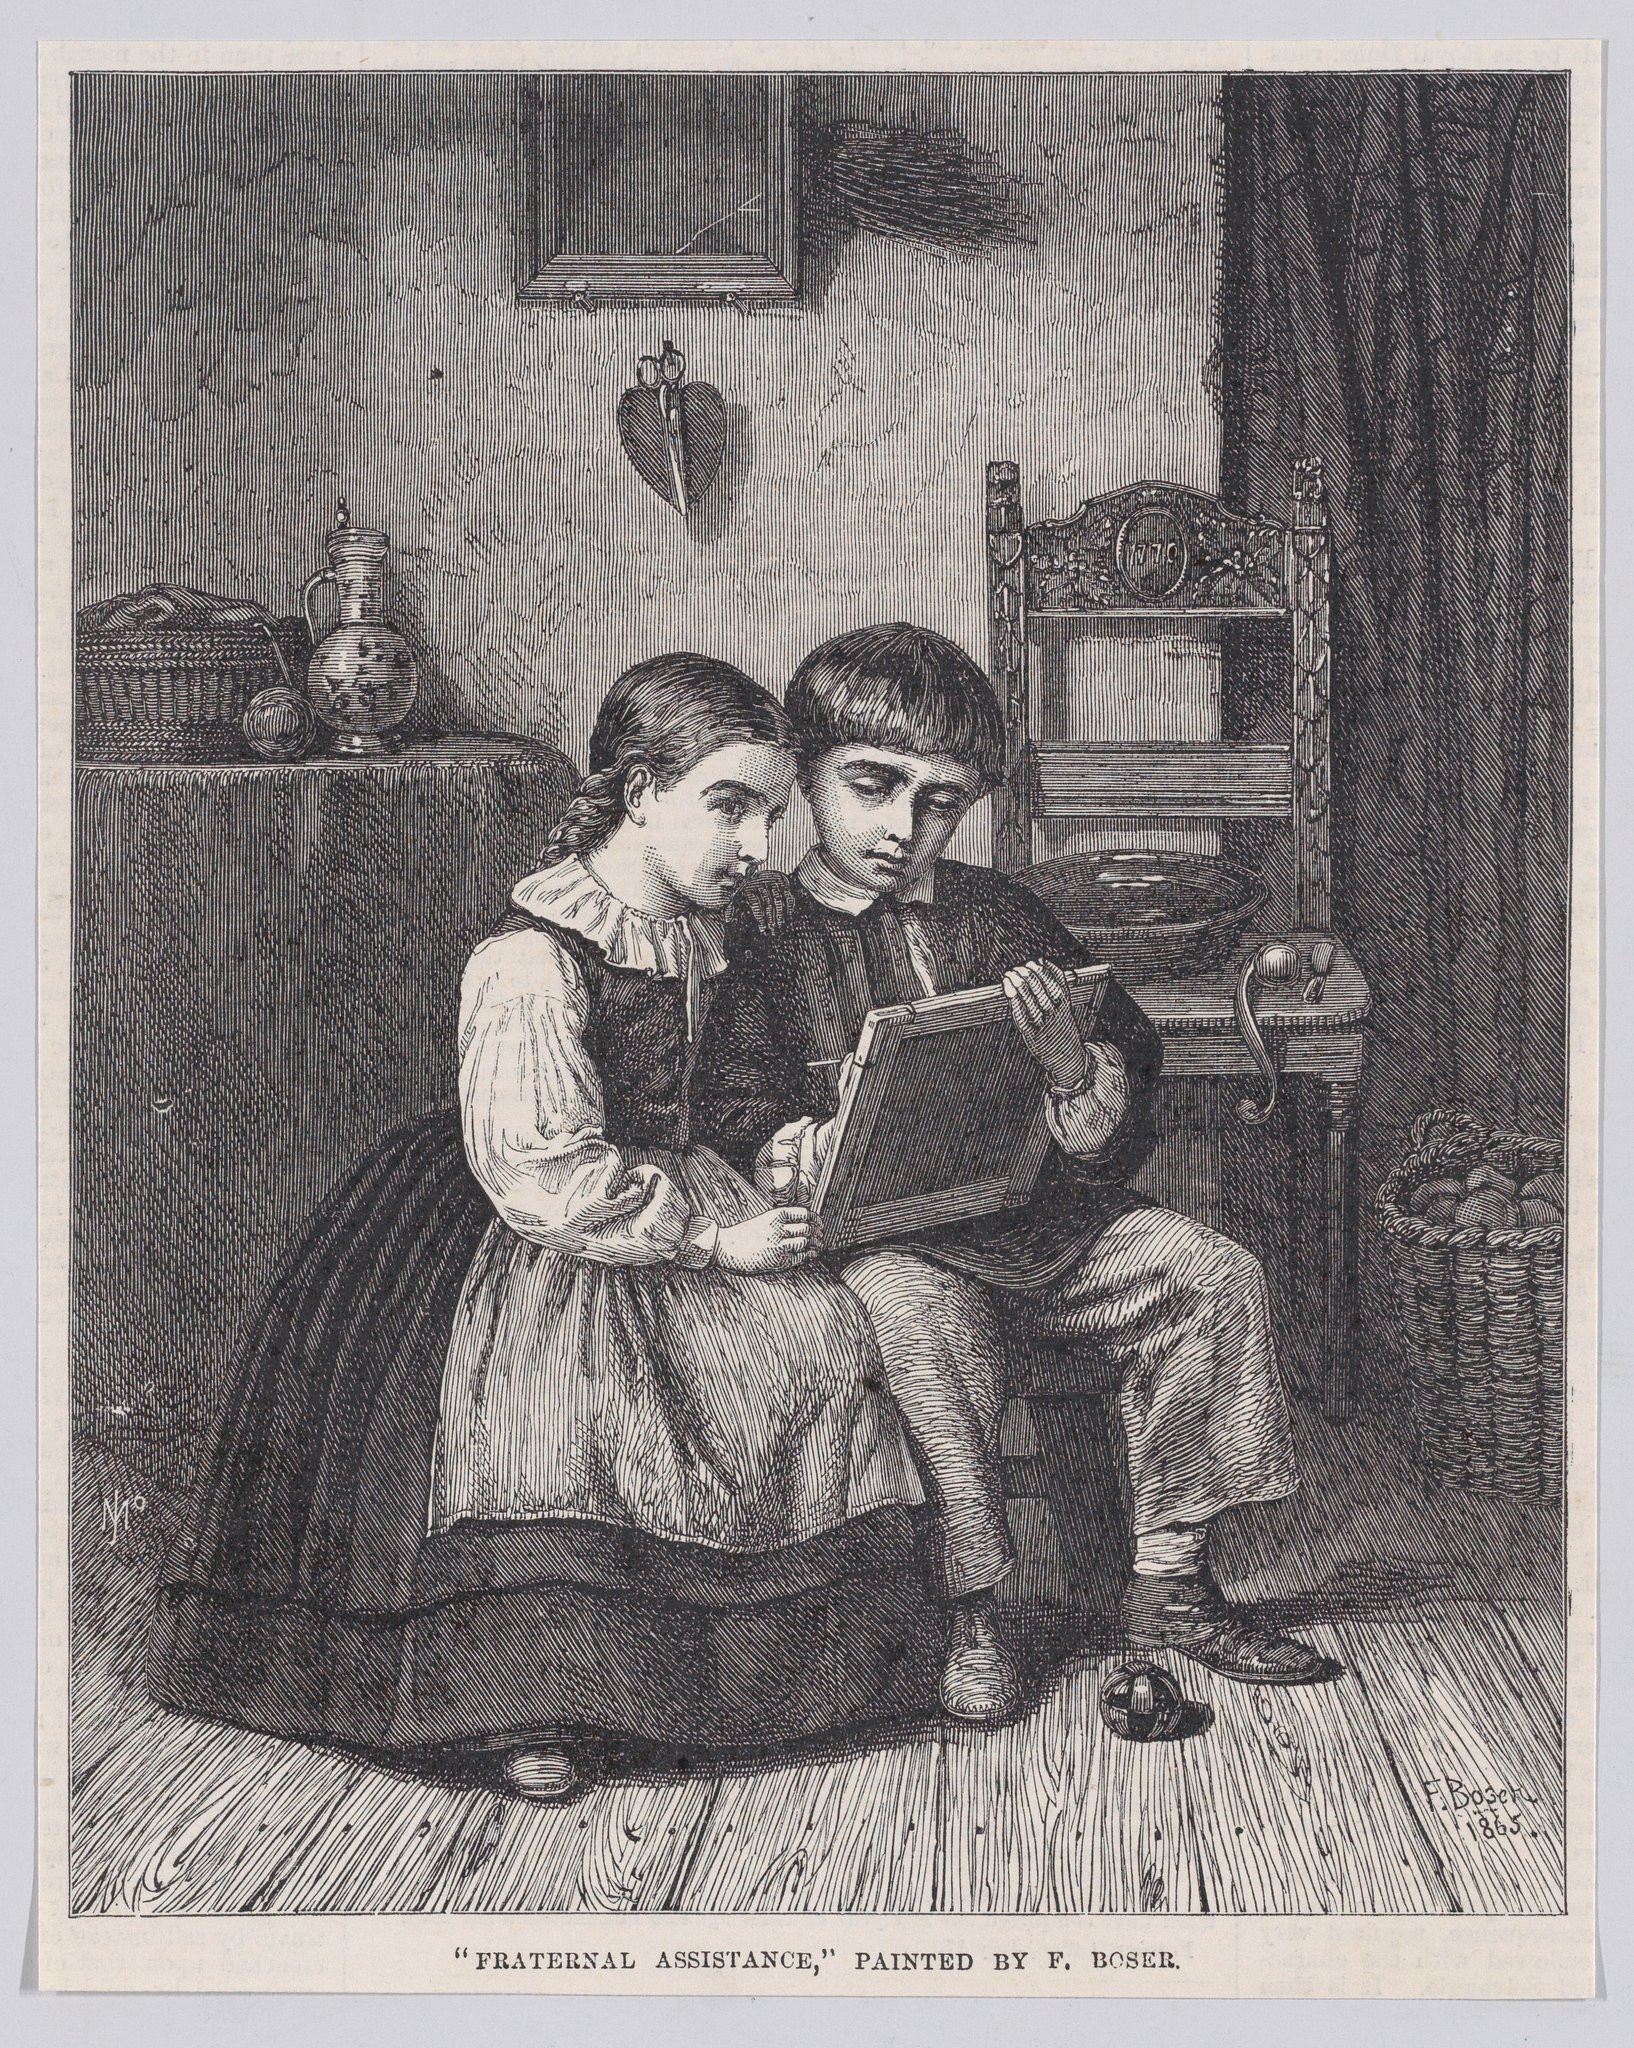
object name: print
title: Fraternal Assistance, from "Illustrated London News"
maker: mason jackson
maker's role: engraver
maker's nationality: british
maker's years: 1819-1903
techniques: engraving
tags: boys,girls,writing